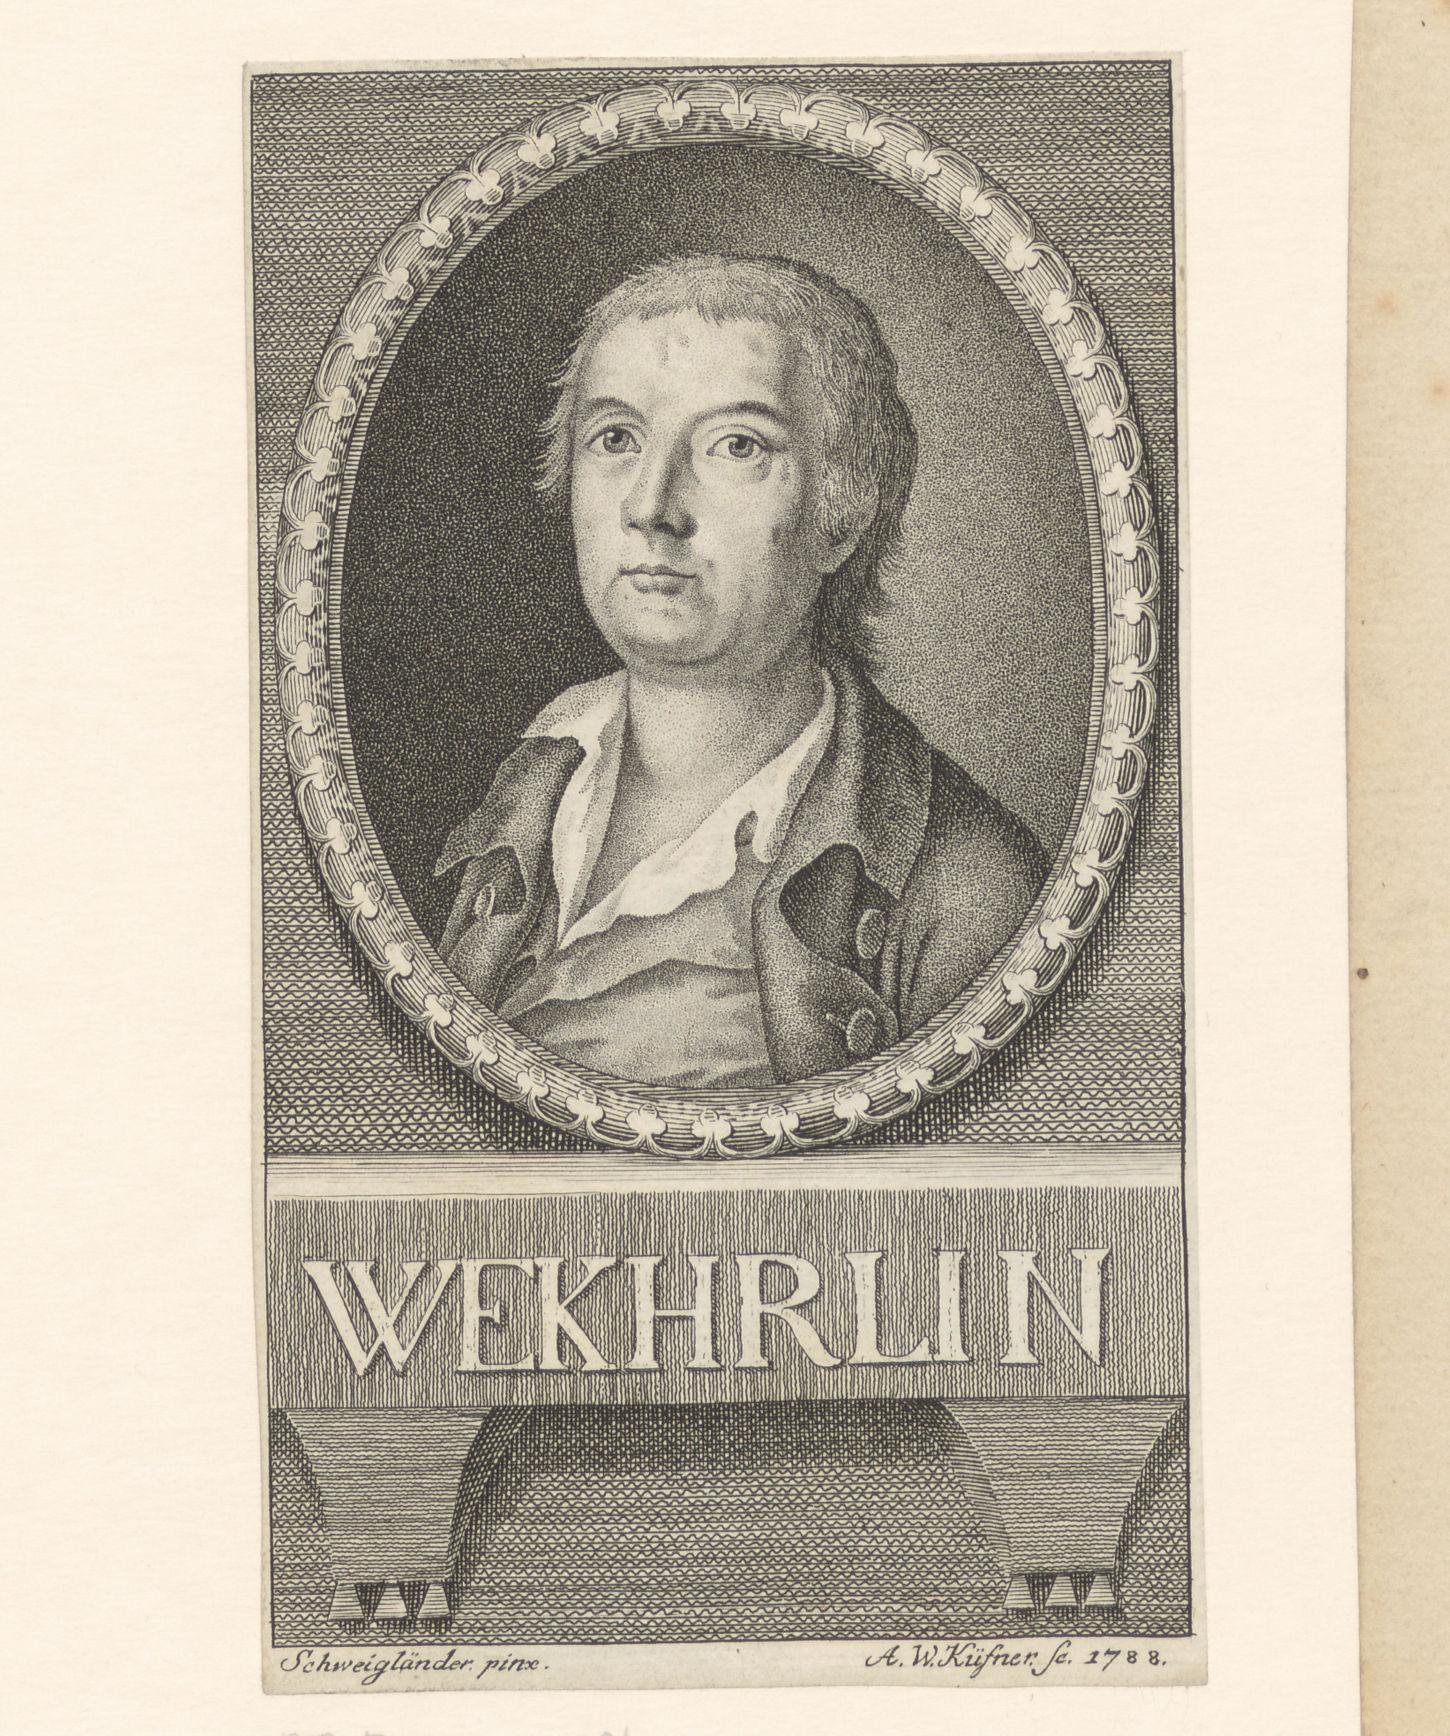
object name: print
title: Portret van Wilhelm Ludwig Wekhrlin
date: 1788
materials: paper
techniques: etching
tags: publisher, historical persons, portrait of a writer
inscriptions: collector's mark: Lugt 2228